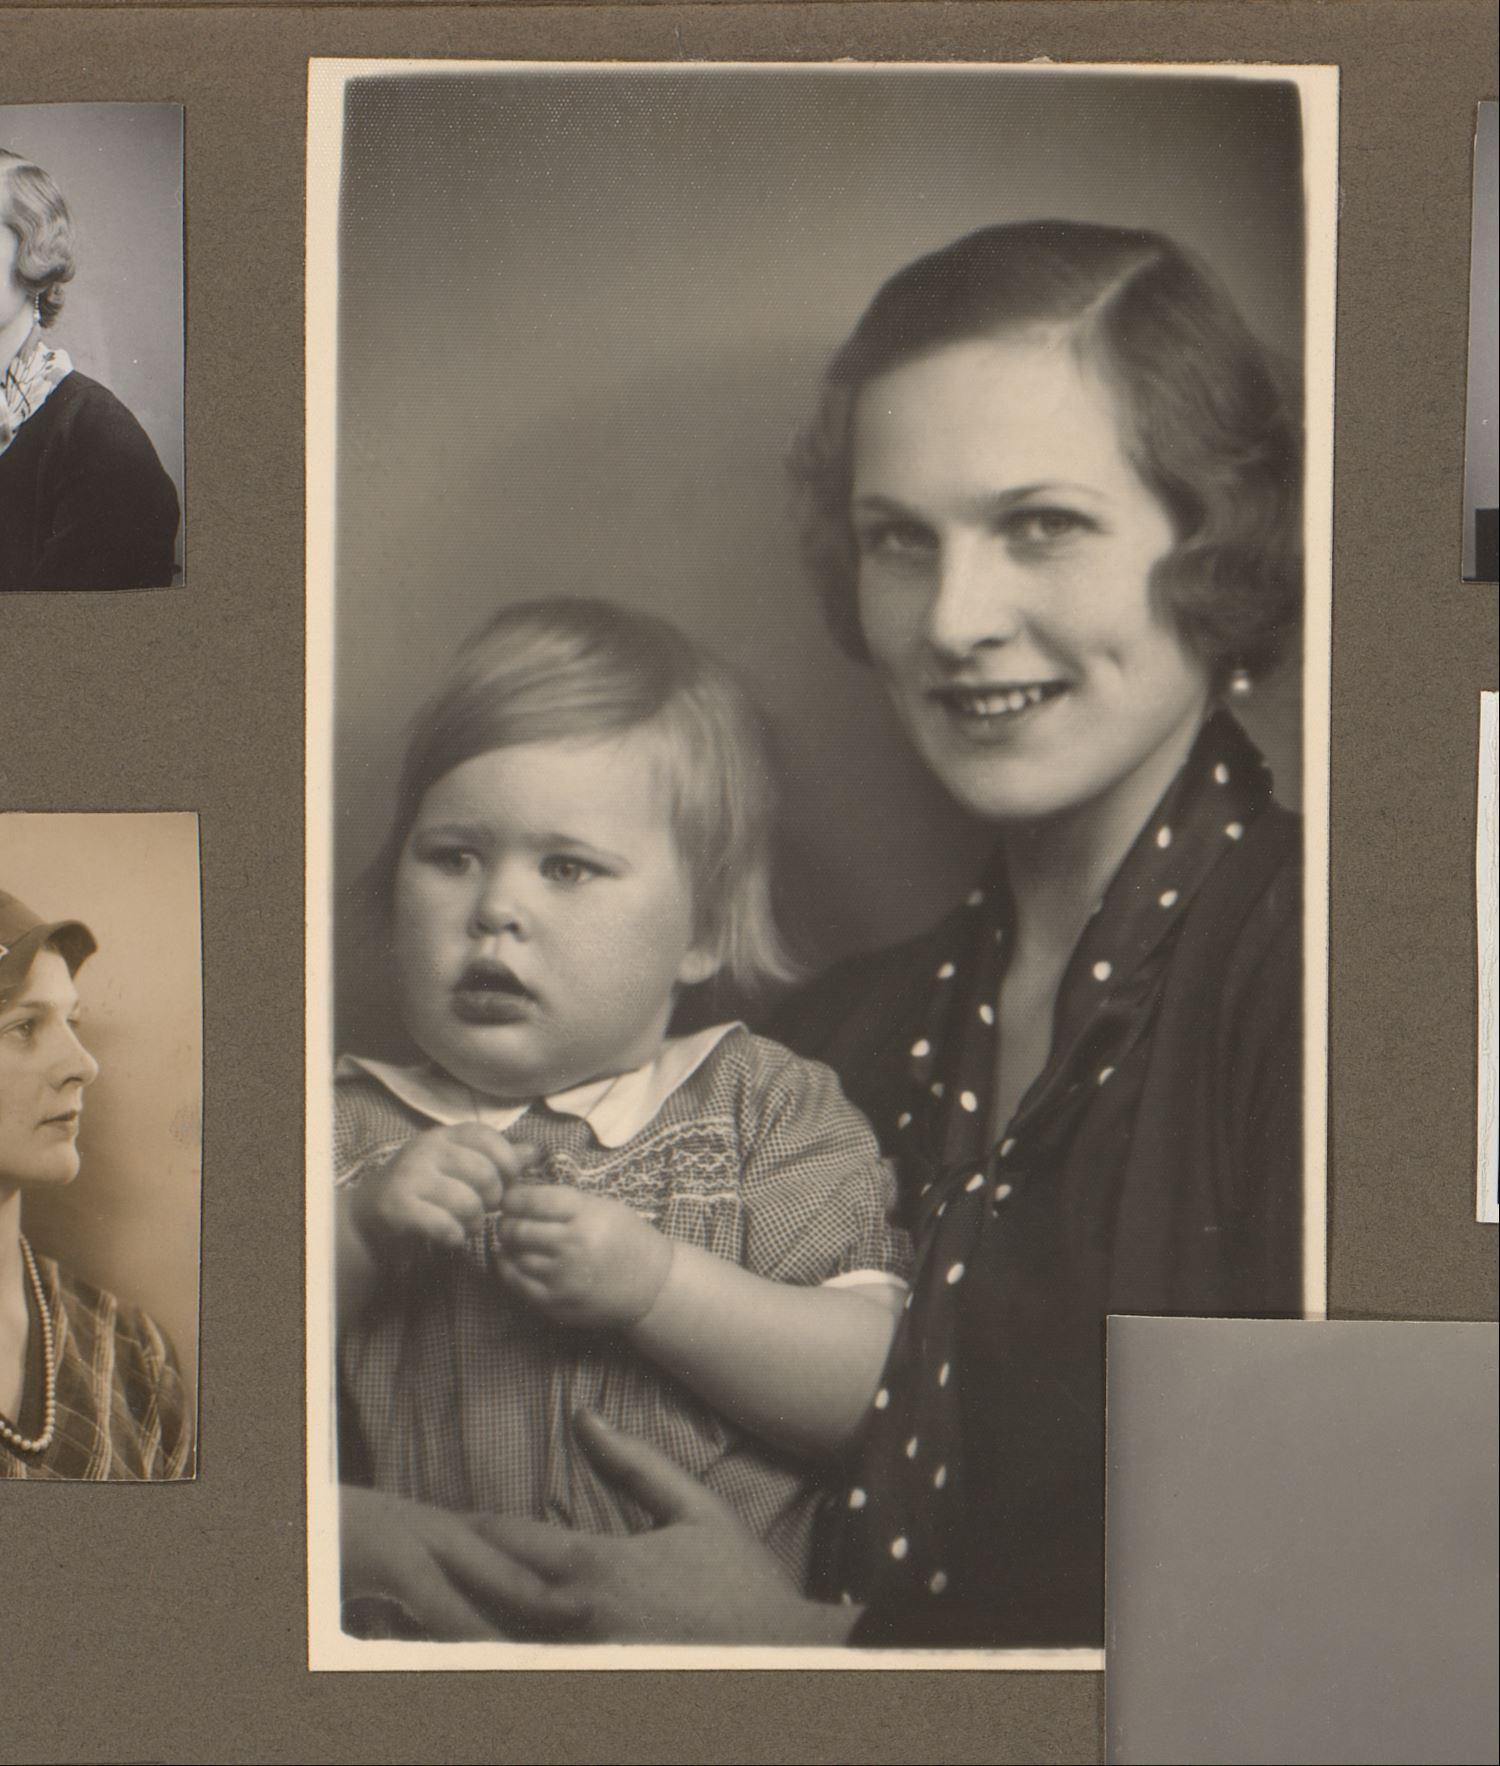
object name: album leaf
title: Portret van Corry Mak van Waay-Zulver met een baby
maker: Anonymous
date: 1934-1935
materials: paper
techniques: gelatin silver print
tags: historical persons - bb - woman, mother and baby or young child